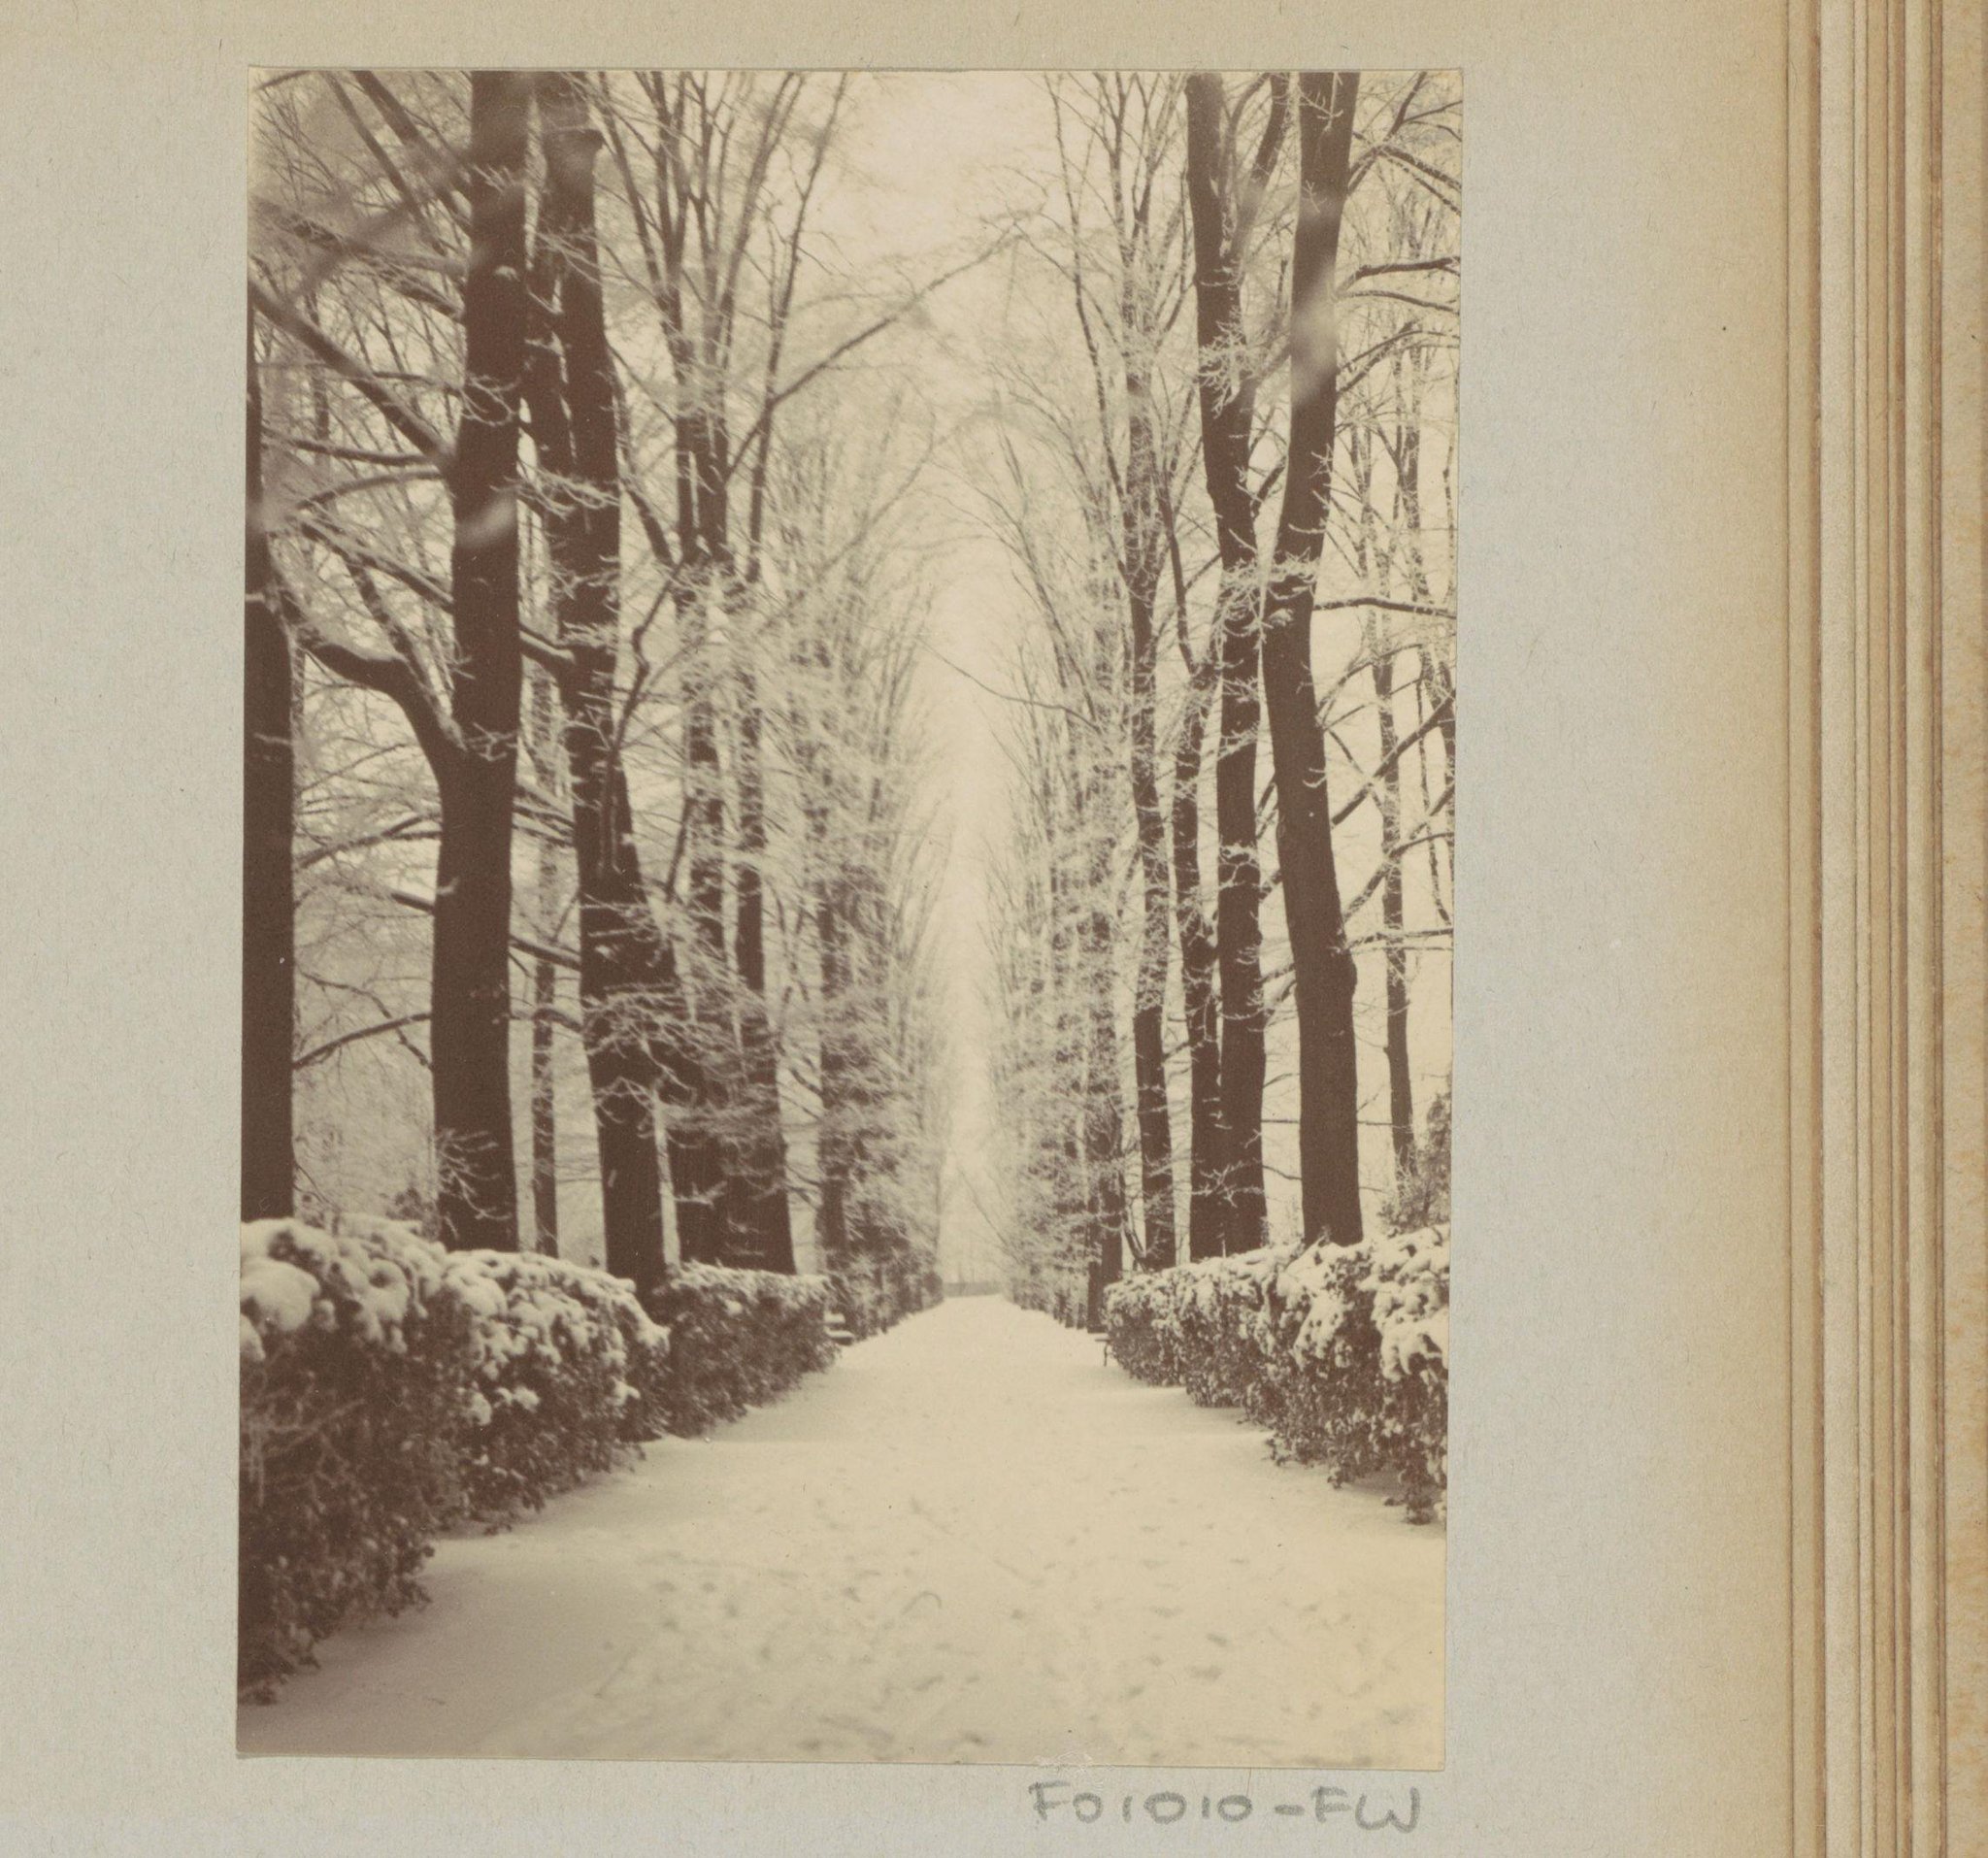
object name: photograph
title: Besneeuwde laan in een park, mogelijk Amsterdam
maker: Anonymous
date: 1900-1910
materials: photographic support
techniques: daylight paper print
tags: trees, winter landscape; landscape symbolizing winter (the four seasons of the year), snow, lane, alley, public gardens, park, amsterdam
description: Onderdeel van Familiealbum met onder meer foto's van Wijnhandel Kraaij & Co. Bordeaux-Amsterdam.